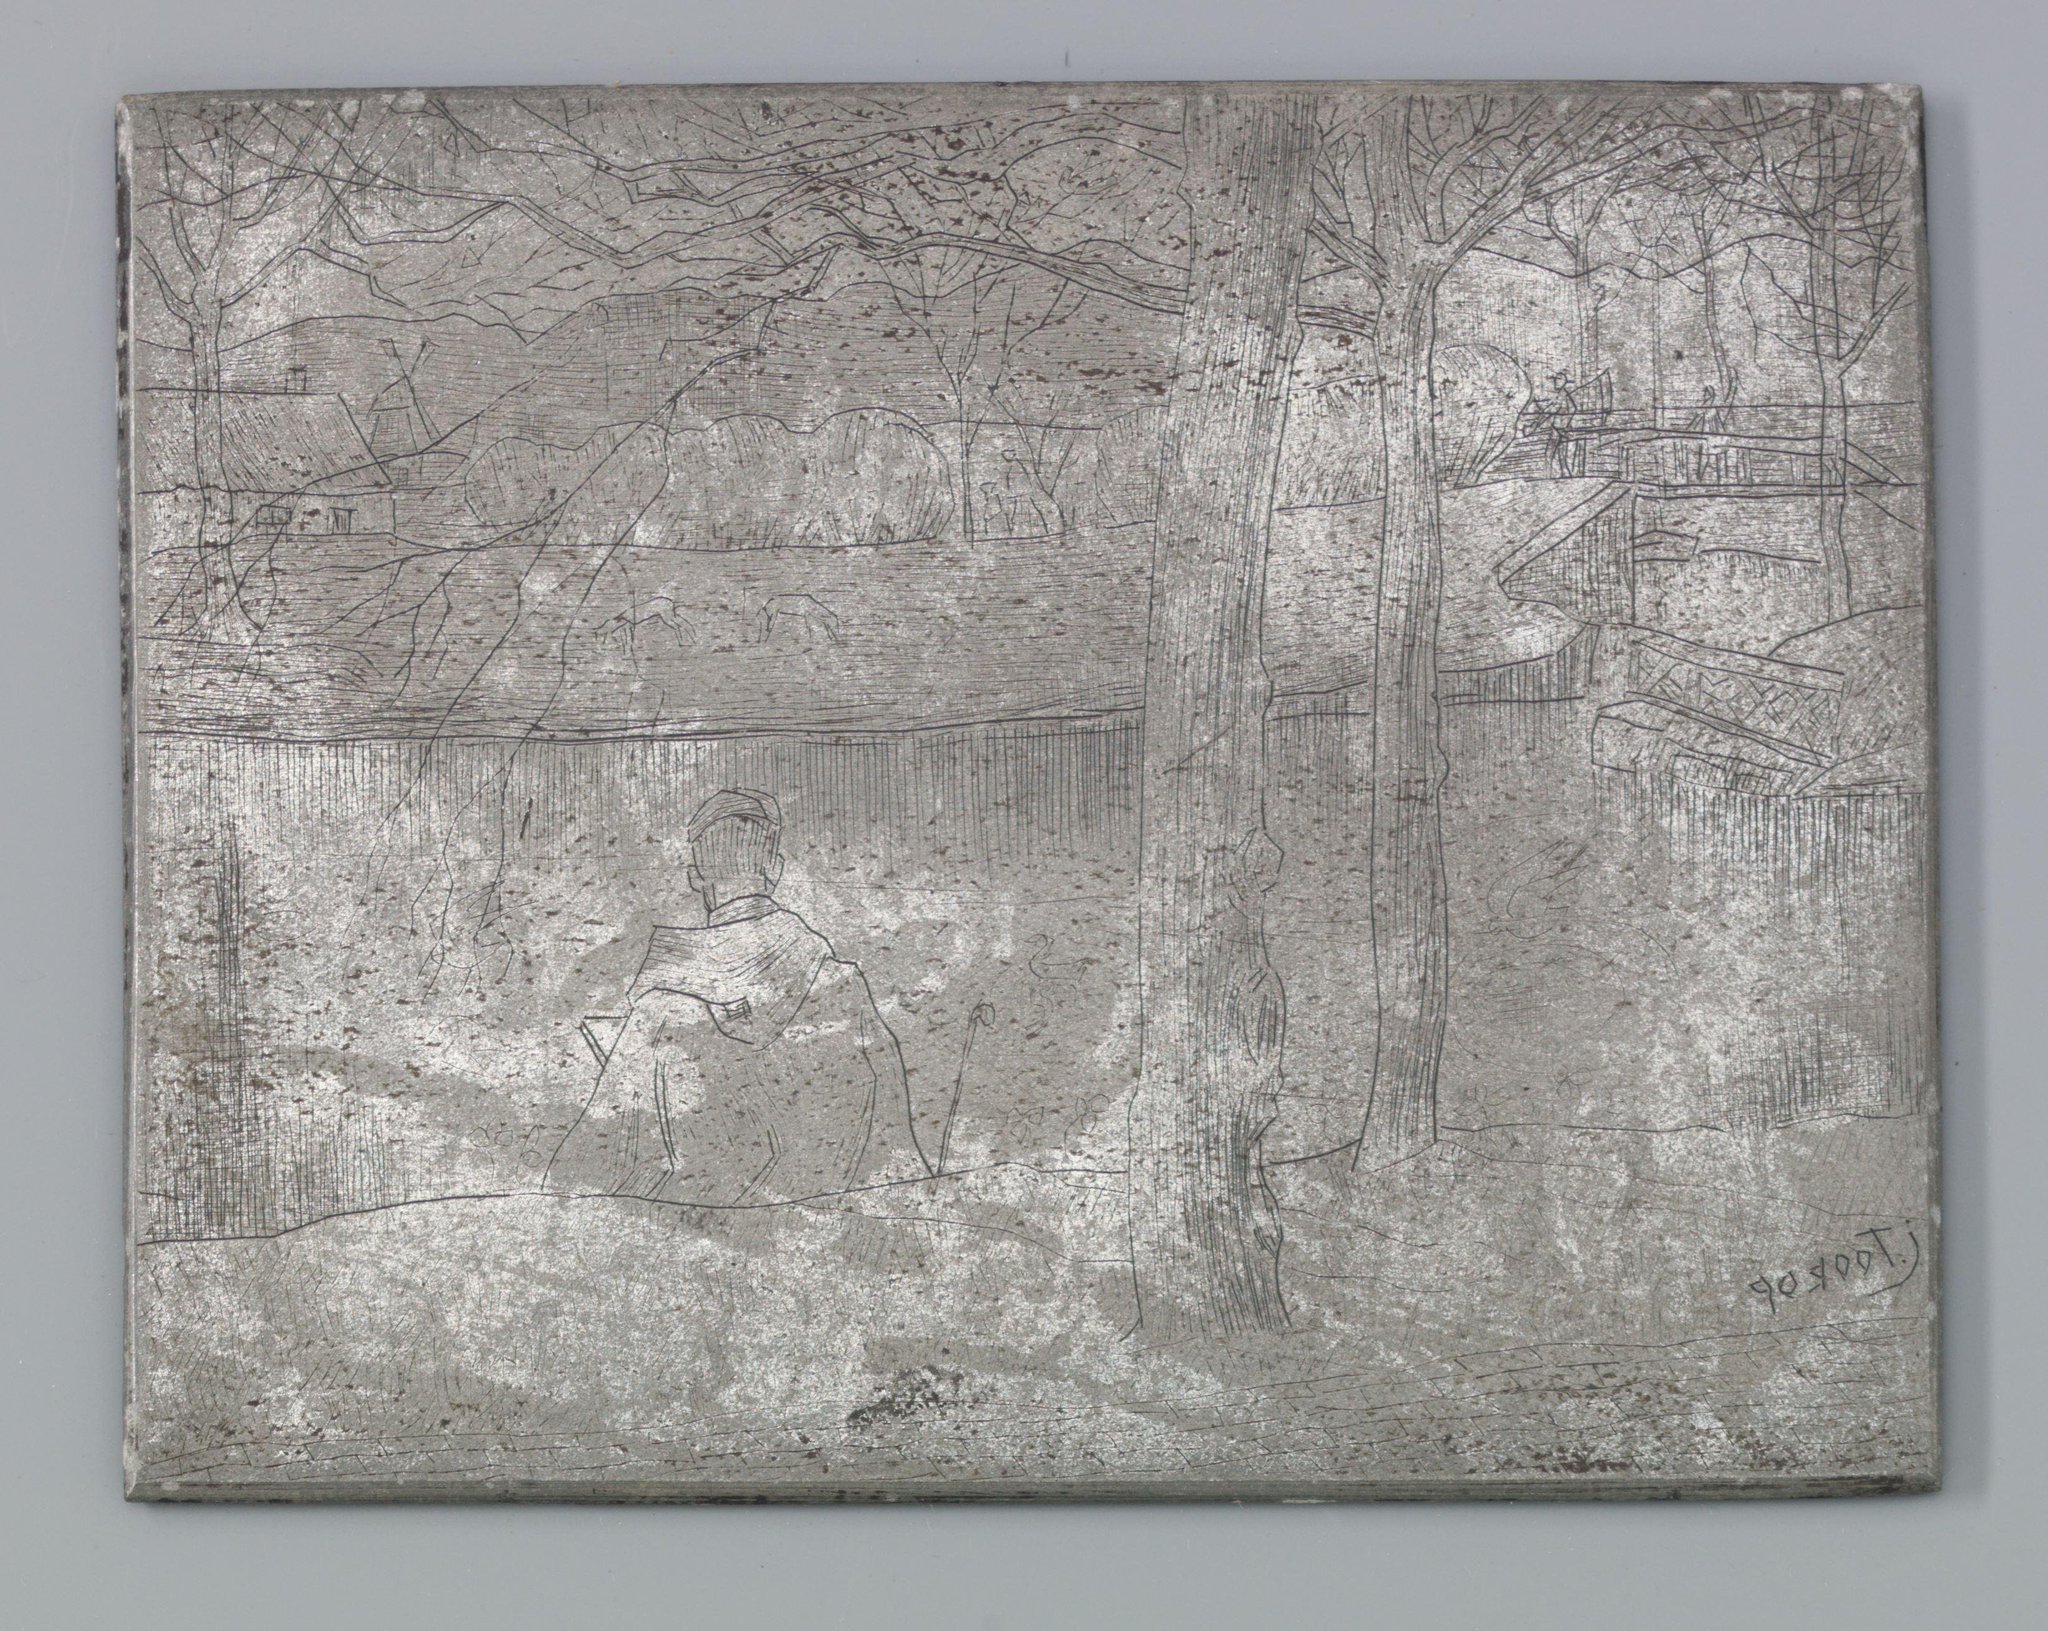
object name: zinkplaat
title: Landschap met tekenaar aan het water, op de rug gezien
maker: jan toorop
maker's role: draughtsman, painter, print maker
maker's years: 1858-1928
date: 1895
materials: zinc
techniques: drypoint